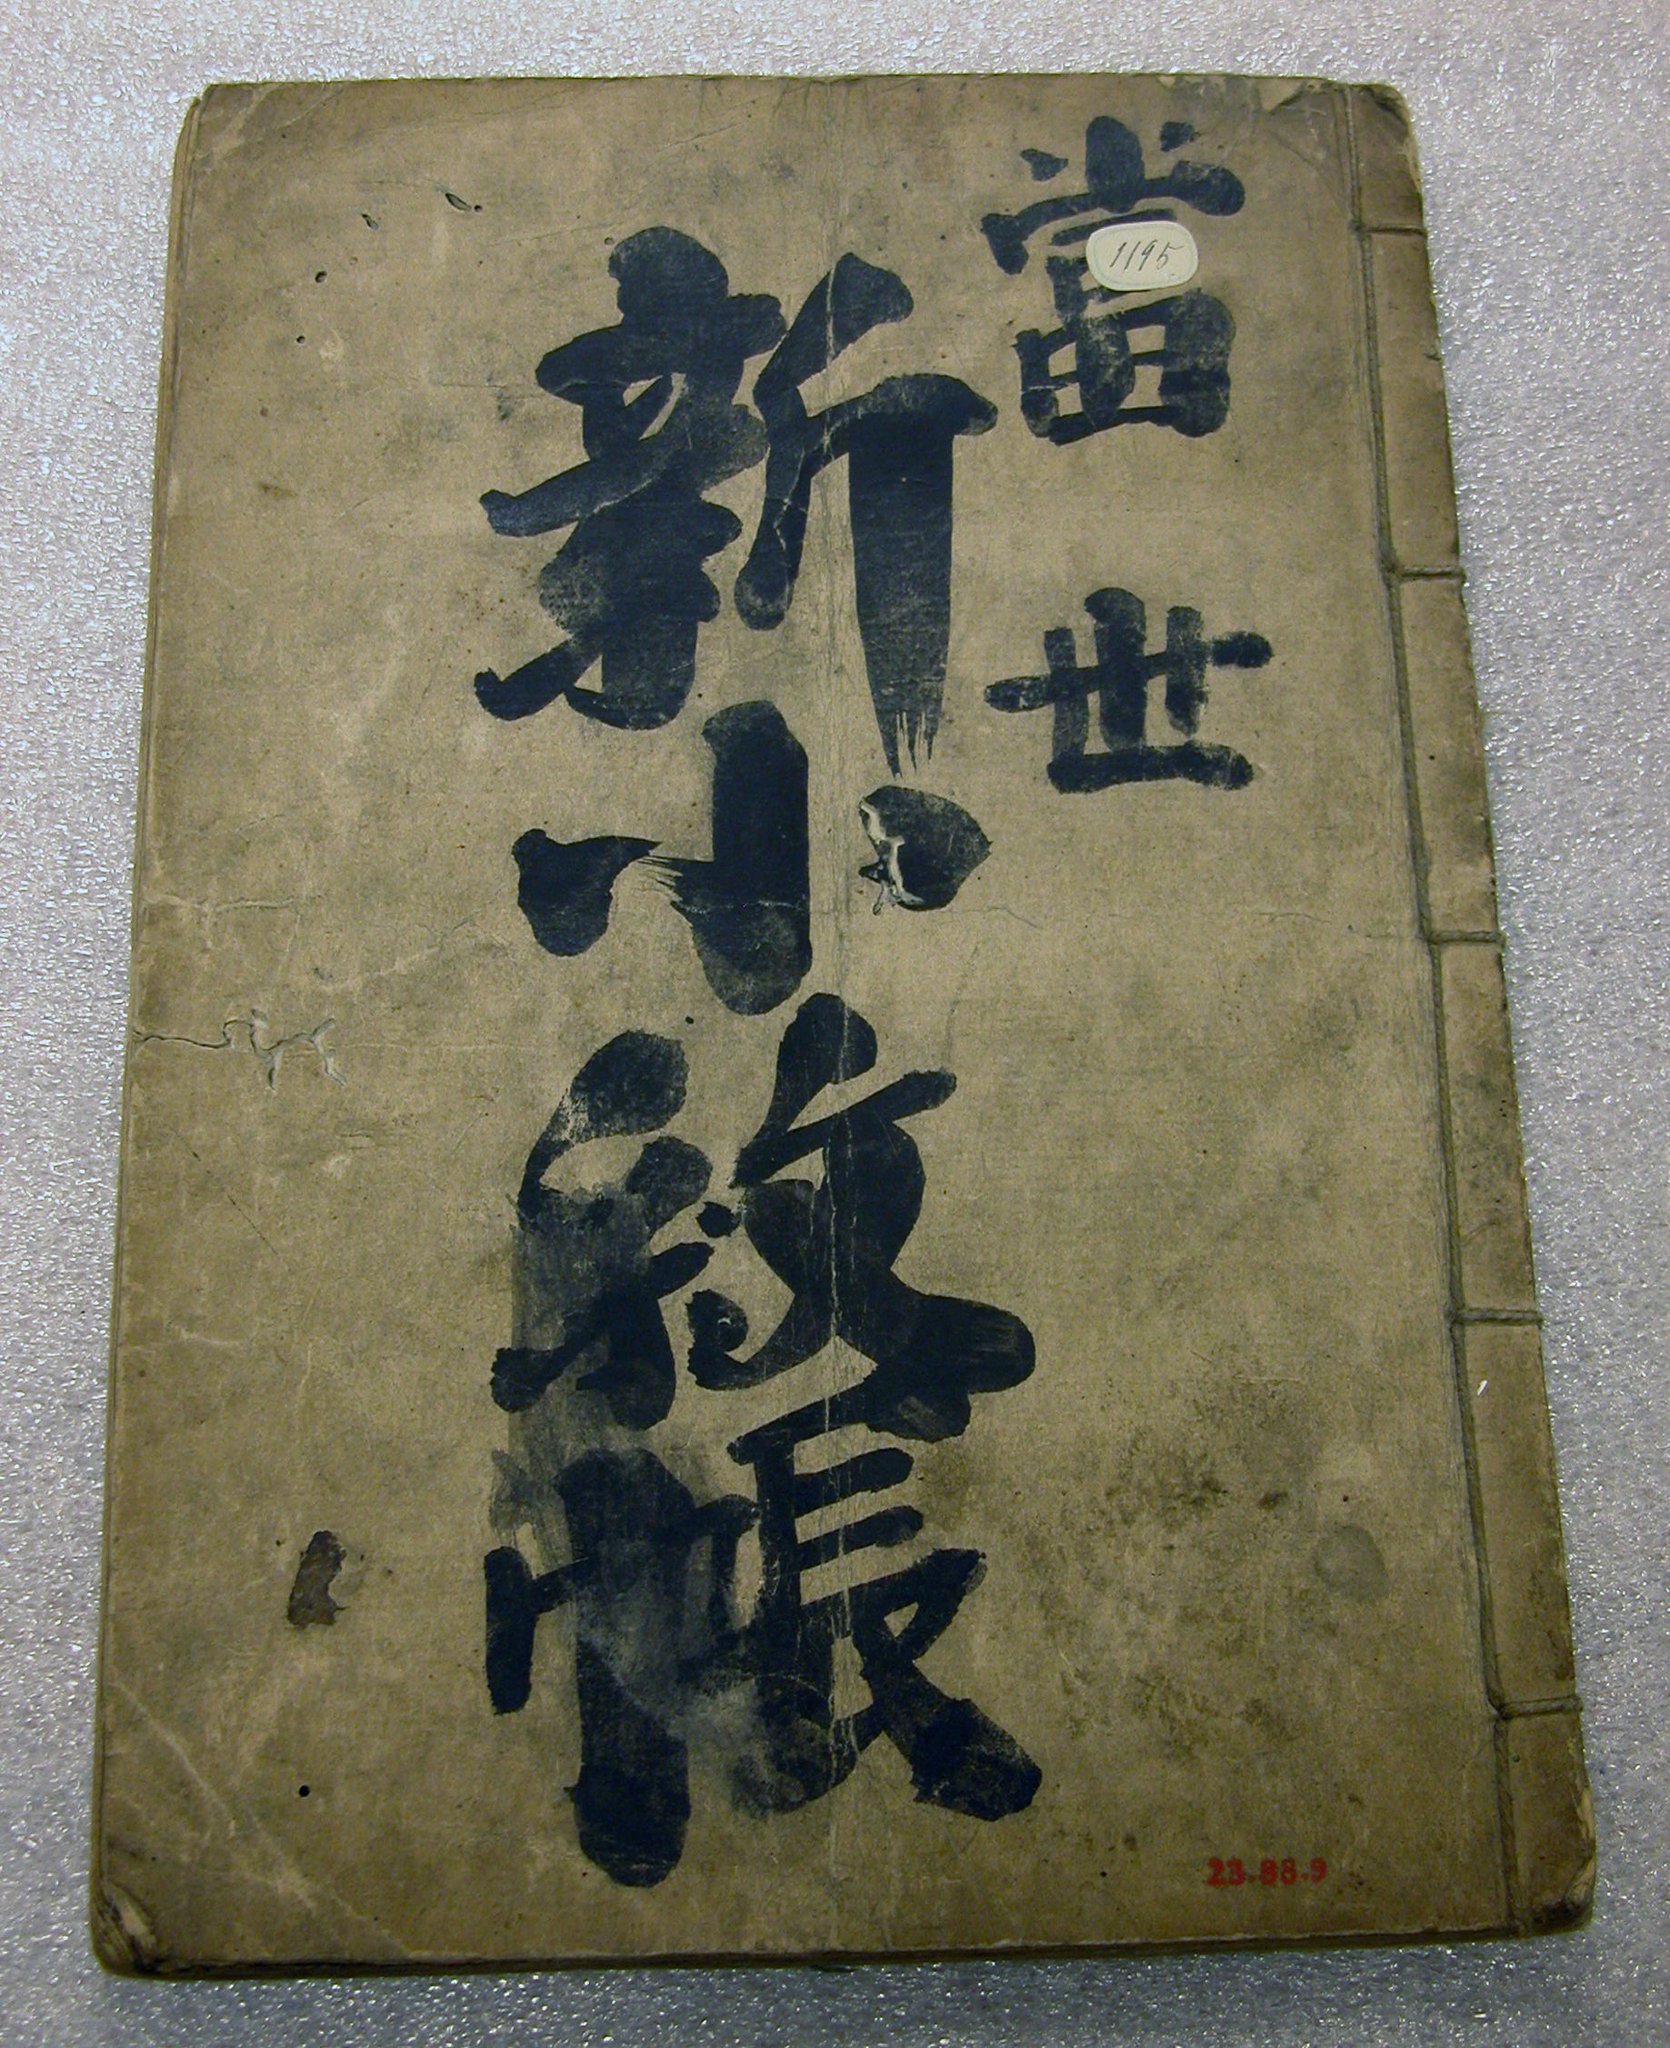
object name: illustrated book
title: Book of Designs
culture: japanese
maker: unidentified artist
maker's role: artist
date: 1700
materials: ink, paper